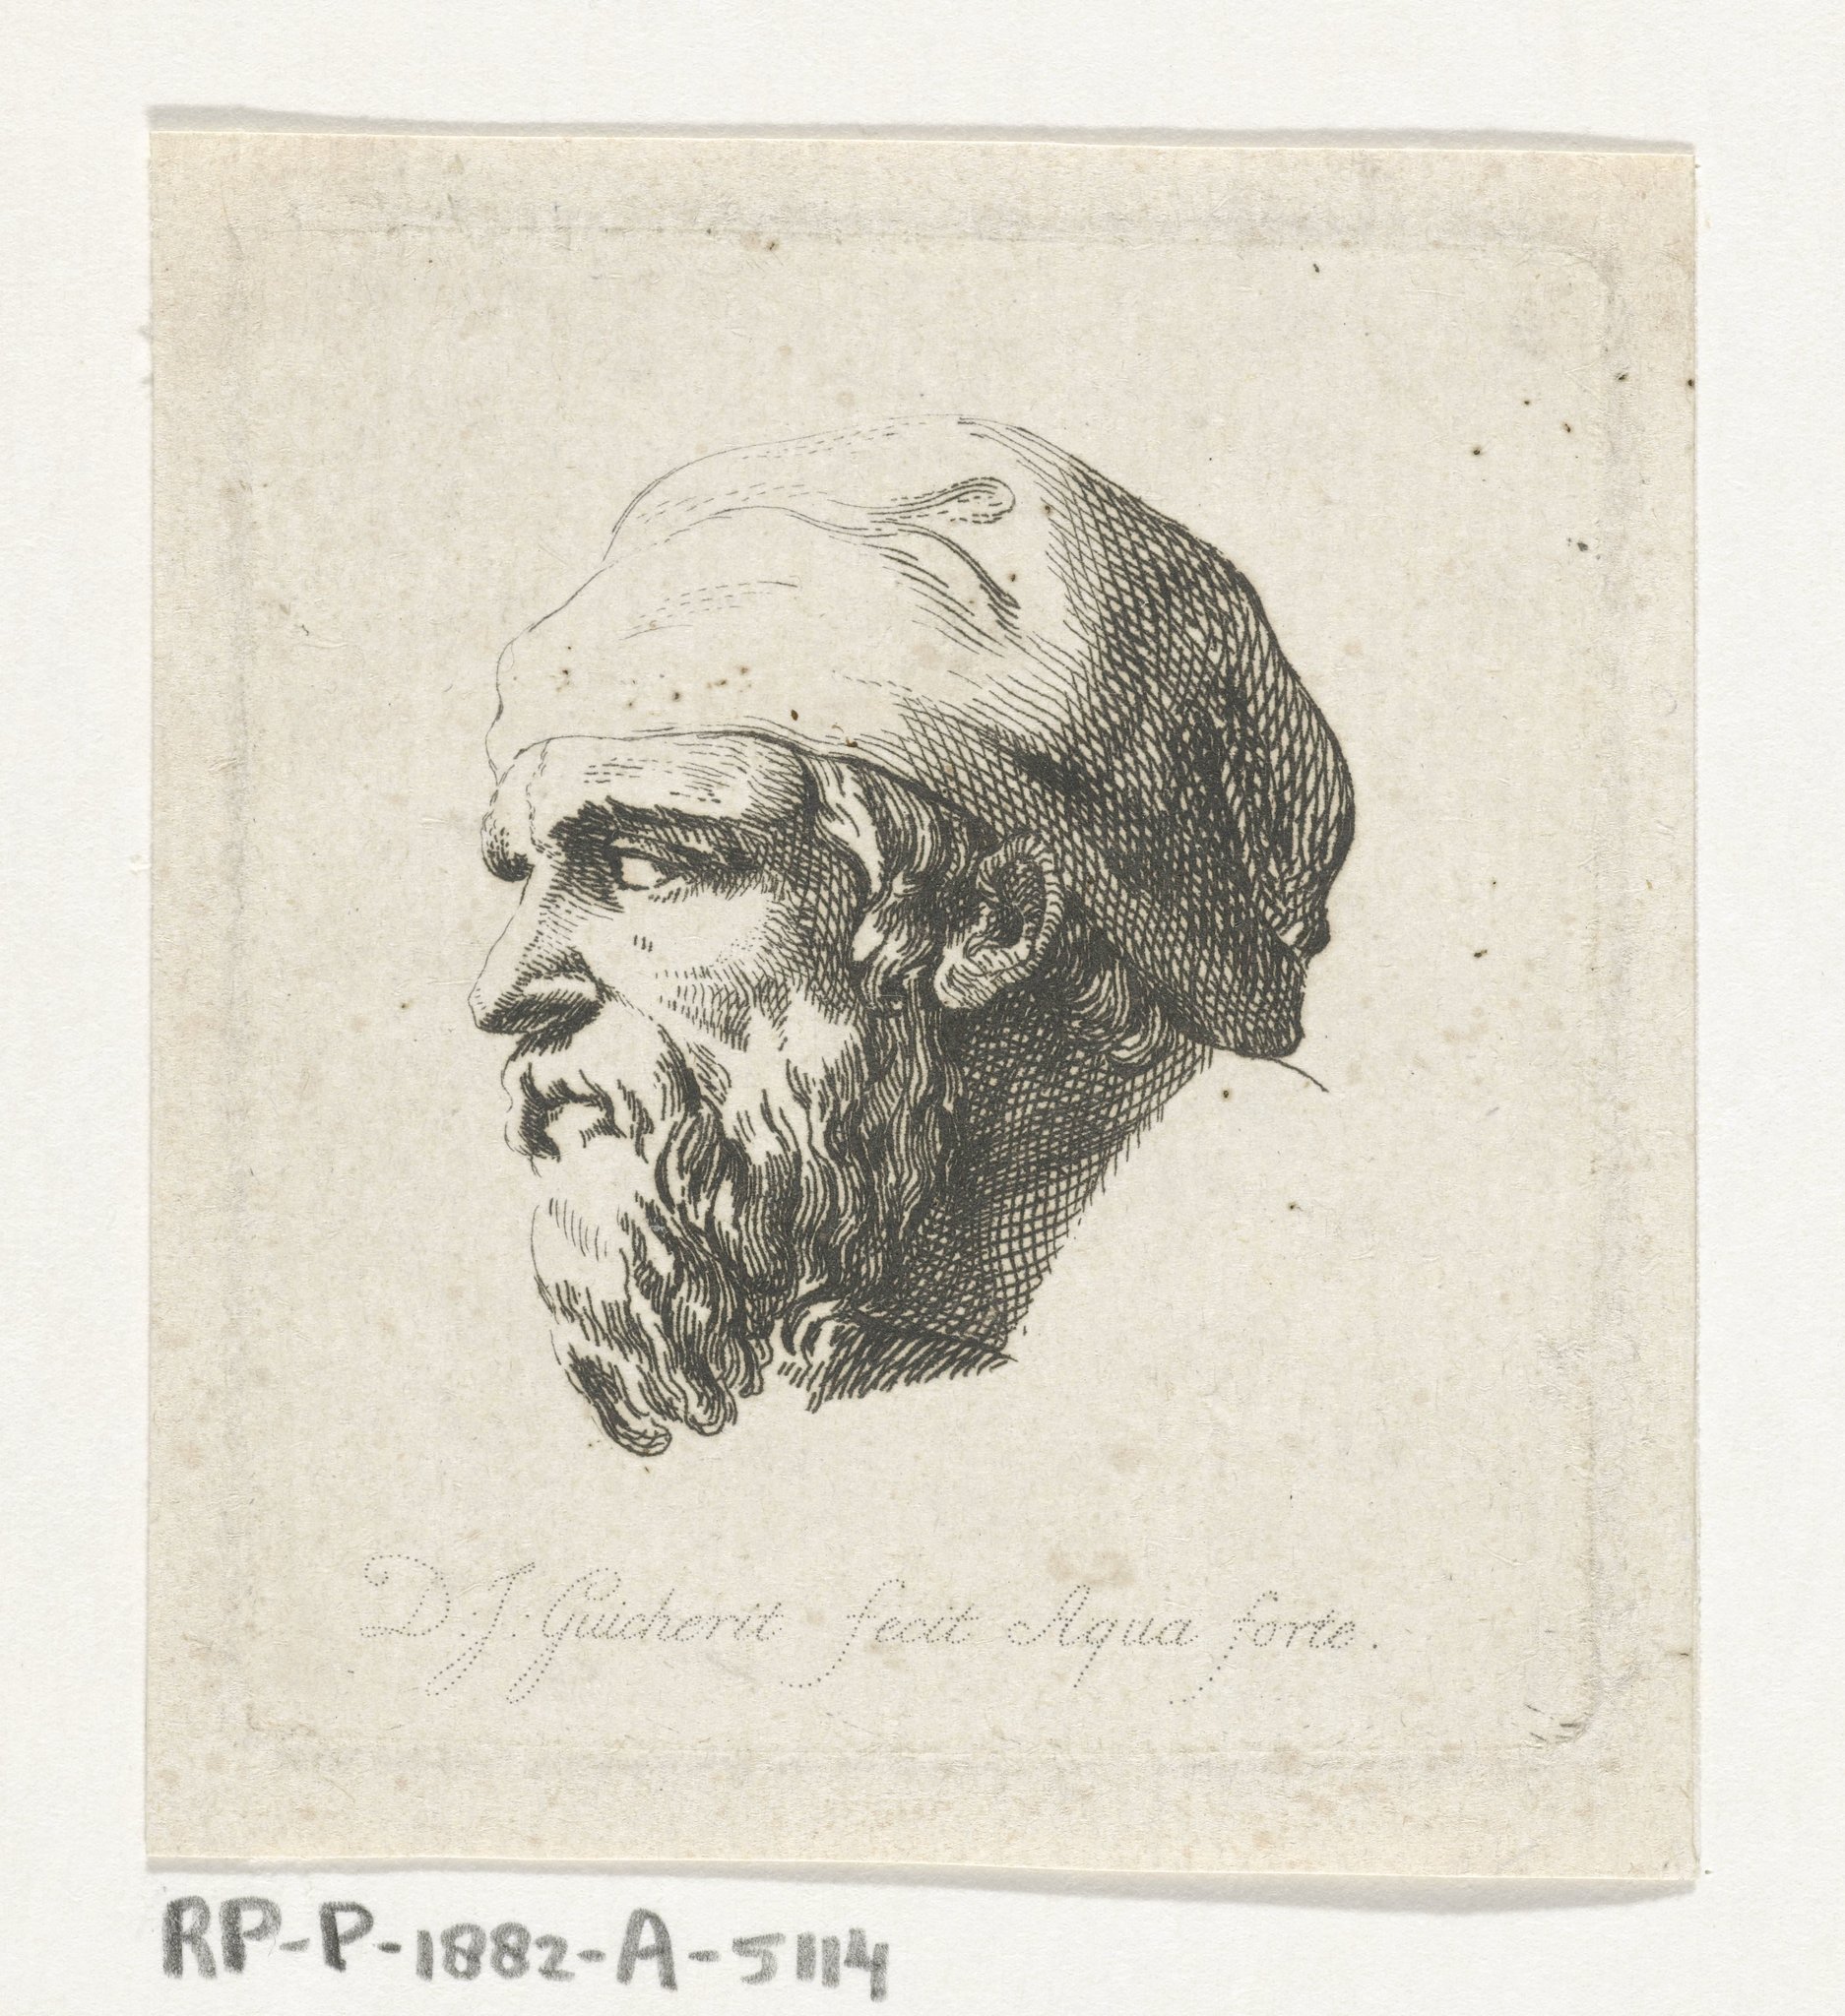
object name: print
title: Hoofd van man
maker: daniël jean guicherit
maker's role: print maker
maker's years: 1763-1813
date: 1778-1813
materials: paper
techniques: etching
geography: northern netherlands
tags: head-gear: hat (+ men's clothes)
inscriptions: collector's mark: Lugt 2228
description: Mannenkop in profiel, met baard en muts waaruit enkele haren te voorschijn komen die het oor onbedekt laten. Onder de voorstelling de signatuur van de kunstenaar.